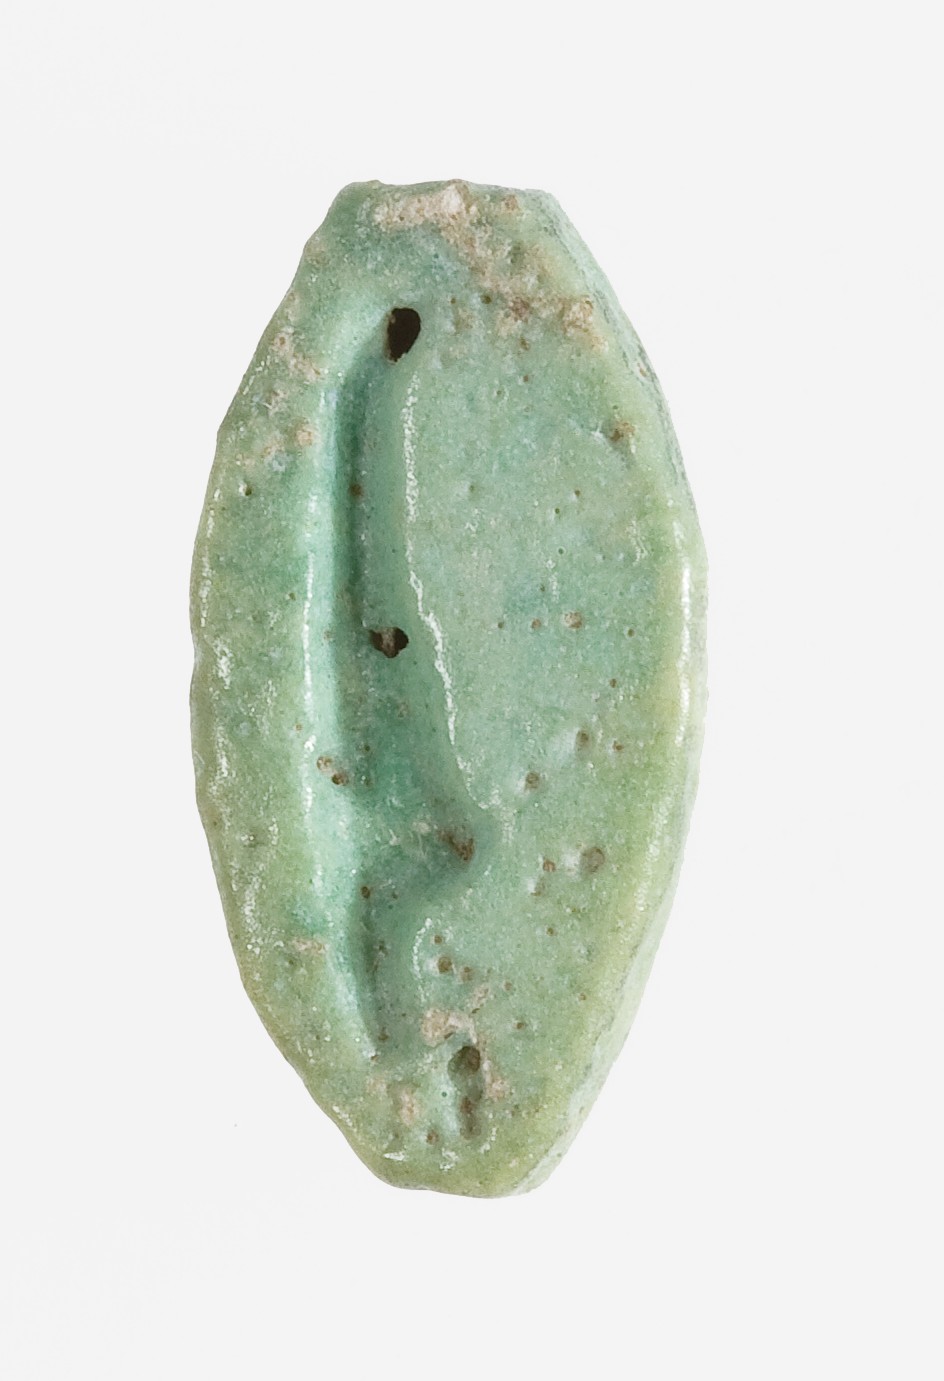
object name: cowroid, maat feather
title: Cowroid Stamp Seal with a Maat Feather Inscribed on the Base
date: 1390-1352 BCE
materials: faience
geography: egypt